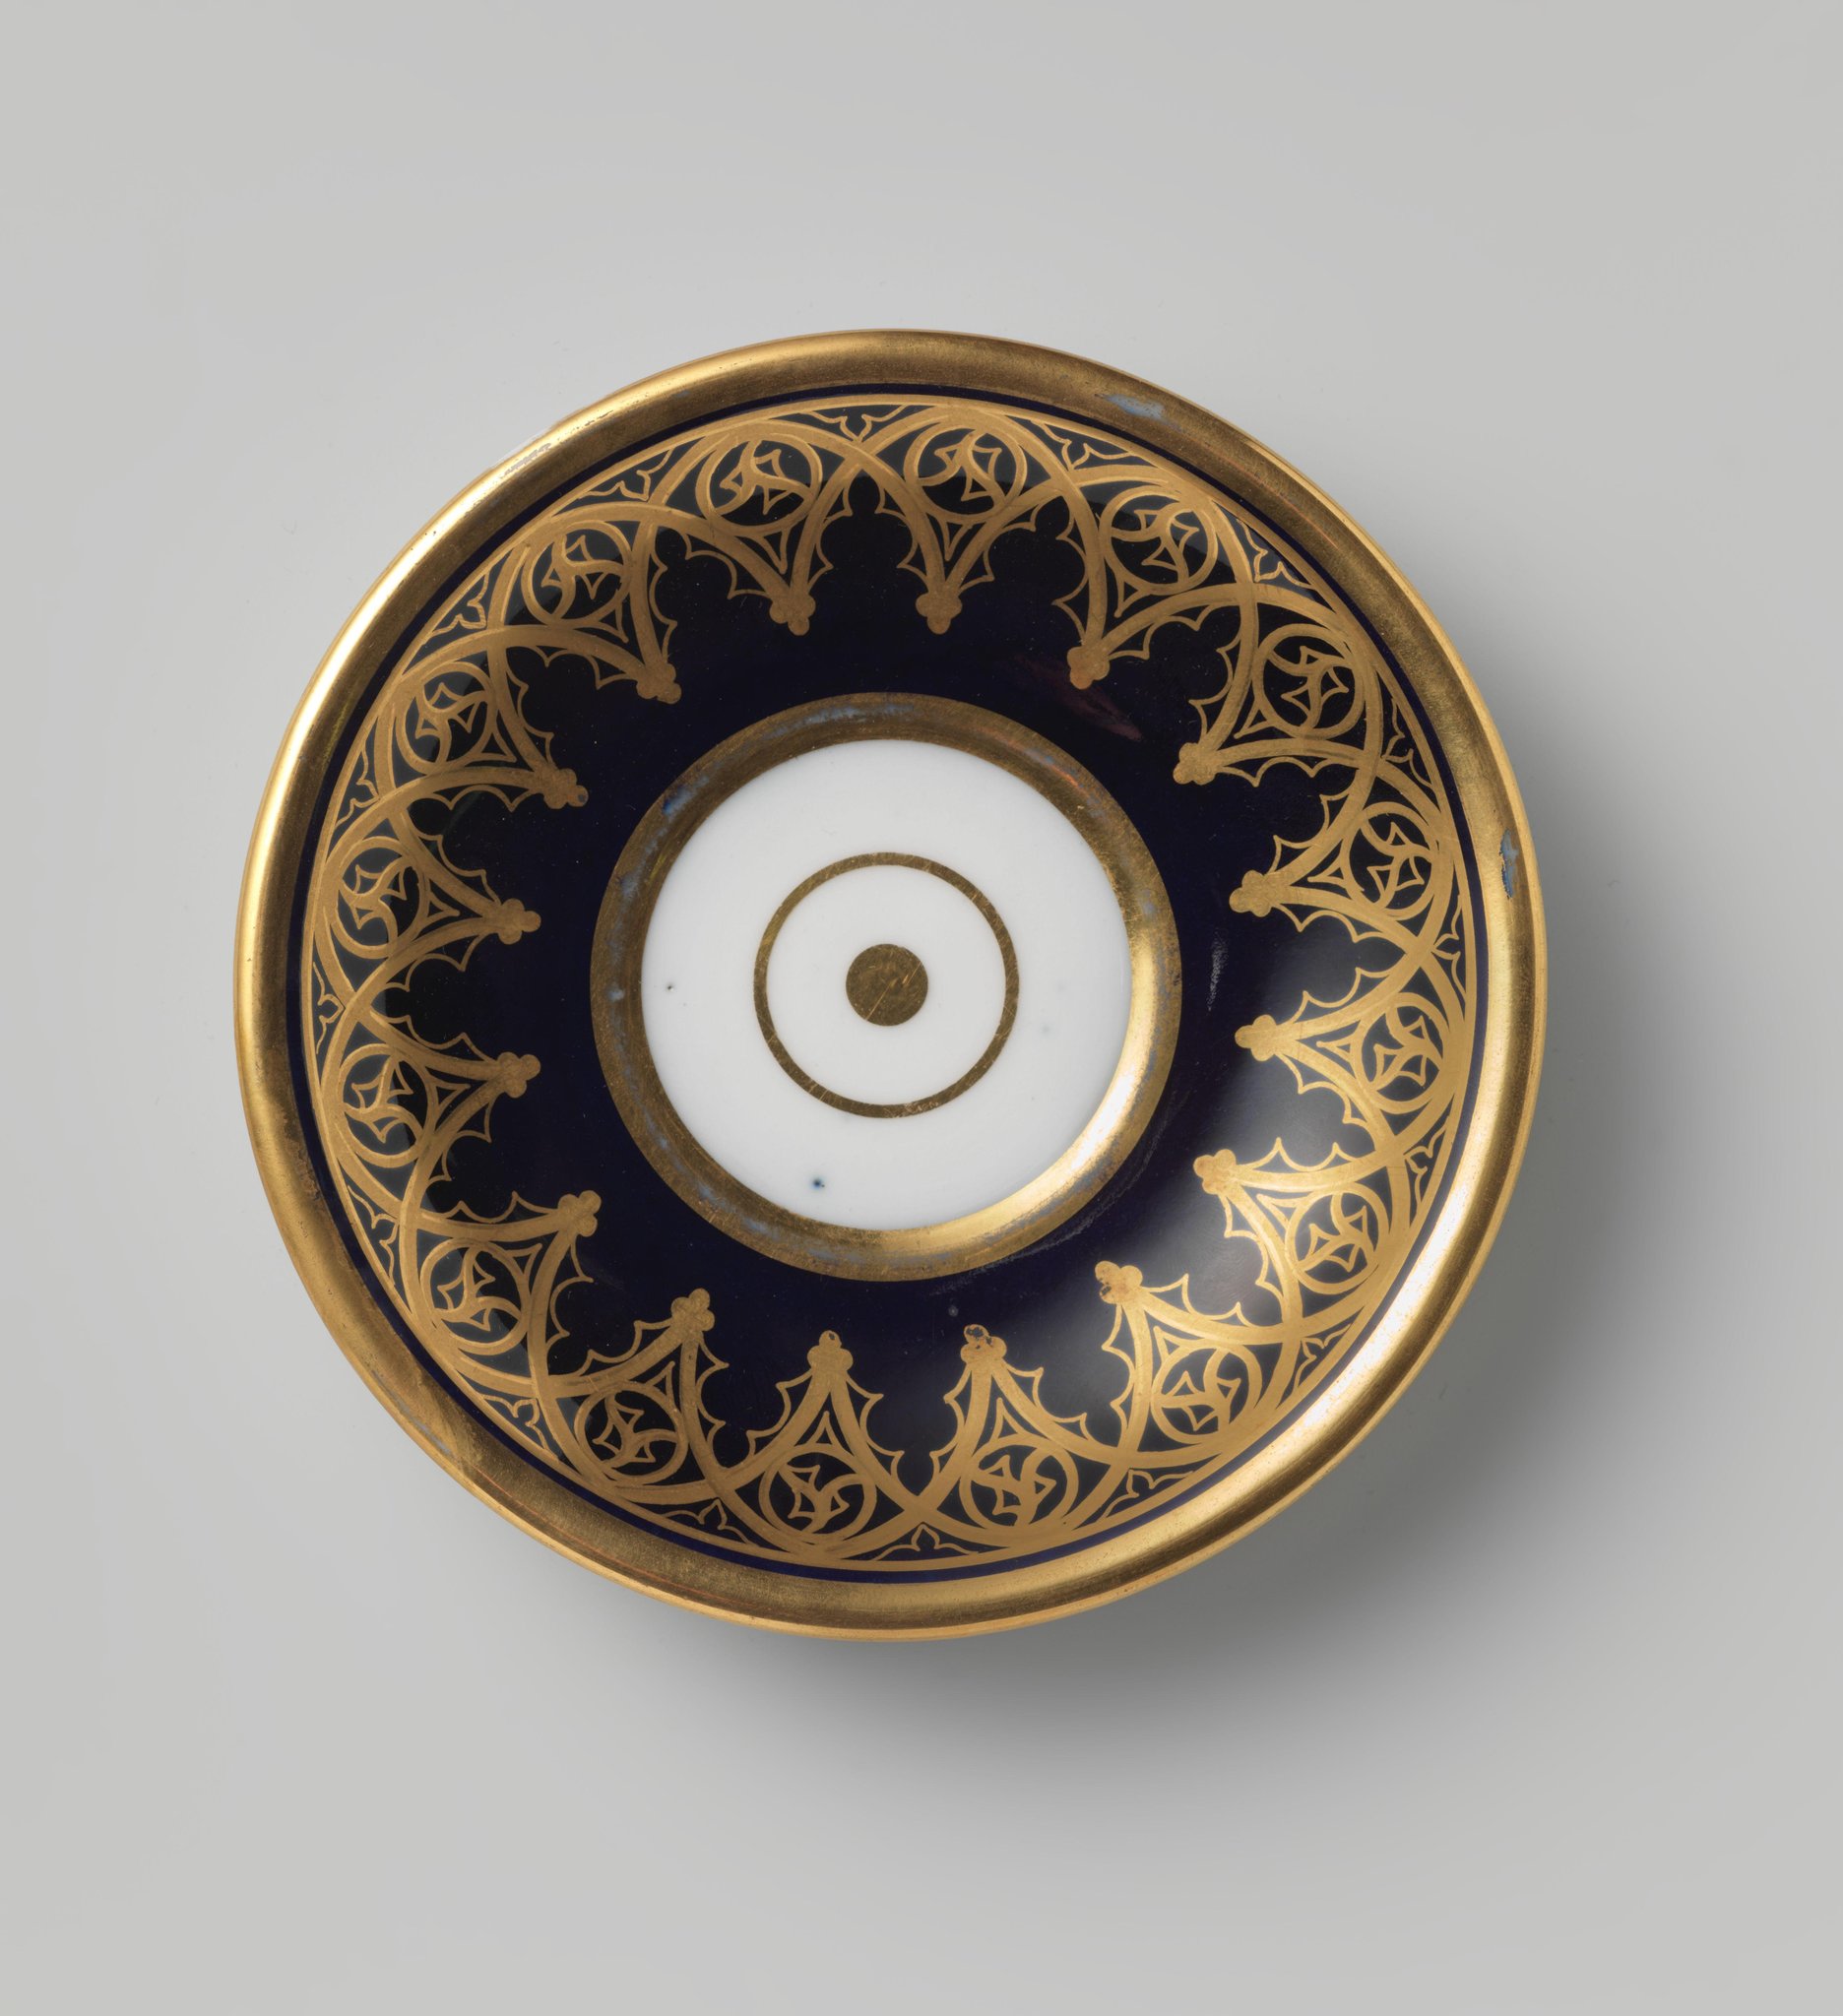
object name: service set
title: Saucer with a gothic arcade decoration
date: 1800-1899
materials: cobalt, glaze, gold, paint, porcelain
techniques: firing, forming, gilding, turning, vitrification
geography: saint-yrieix-la-perche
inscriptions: mark: ‘vis’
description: Schotel van porselein, deel van servies, beschilderd in goud op een koningsblauw fond met een arcademotief met gotische traceringen. Buiten dit decor en voor een groot deel aan de binnenzijde verguld. Gemerkt met een groen visje. Opmerking: zie voor merken ook het algemeen record.